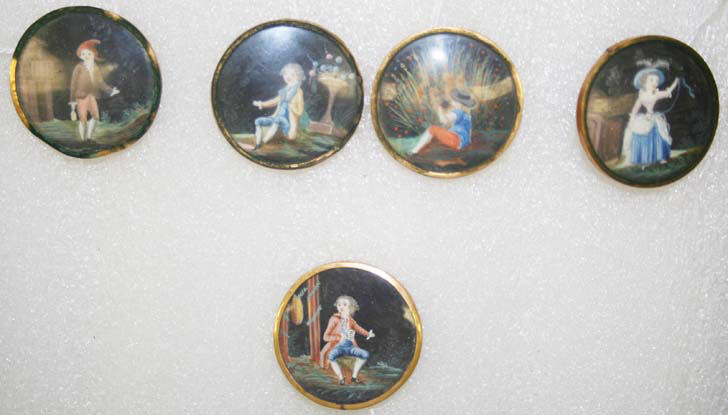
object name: button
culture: french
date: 1775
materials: glass, ivory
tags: men,women